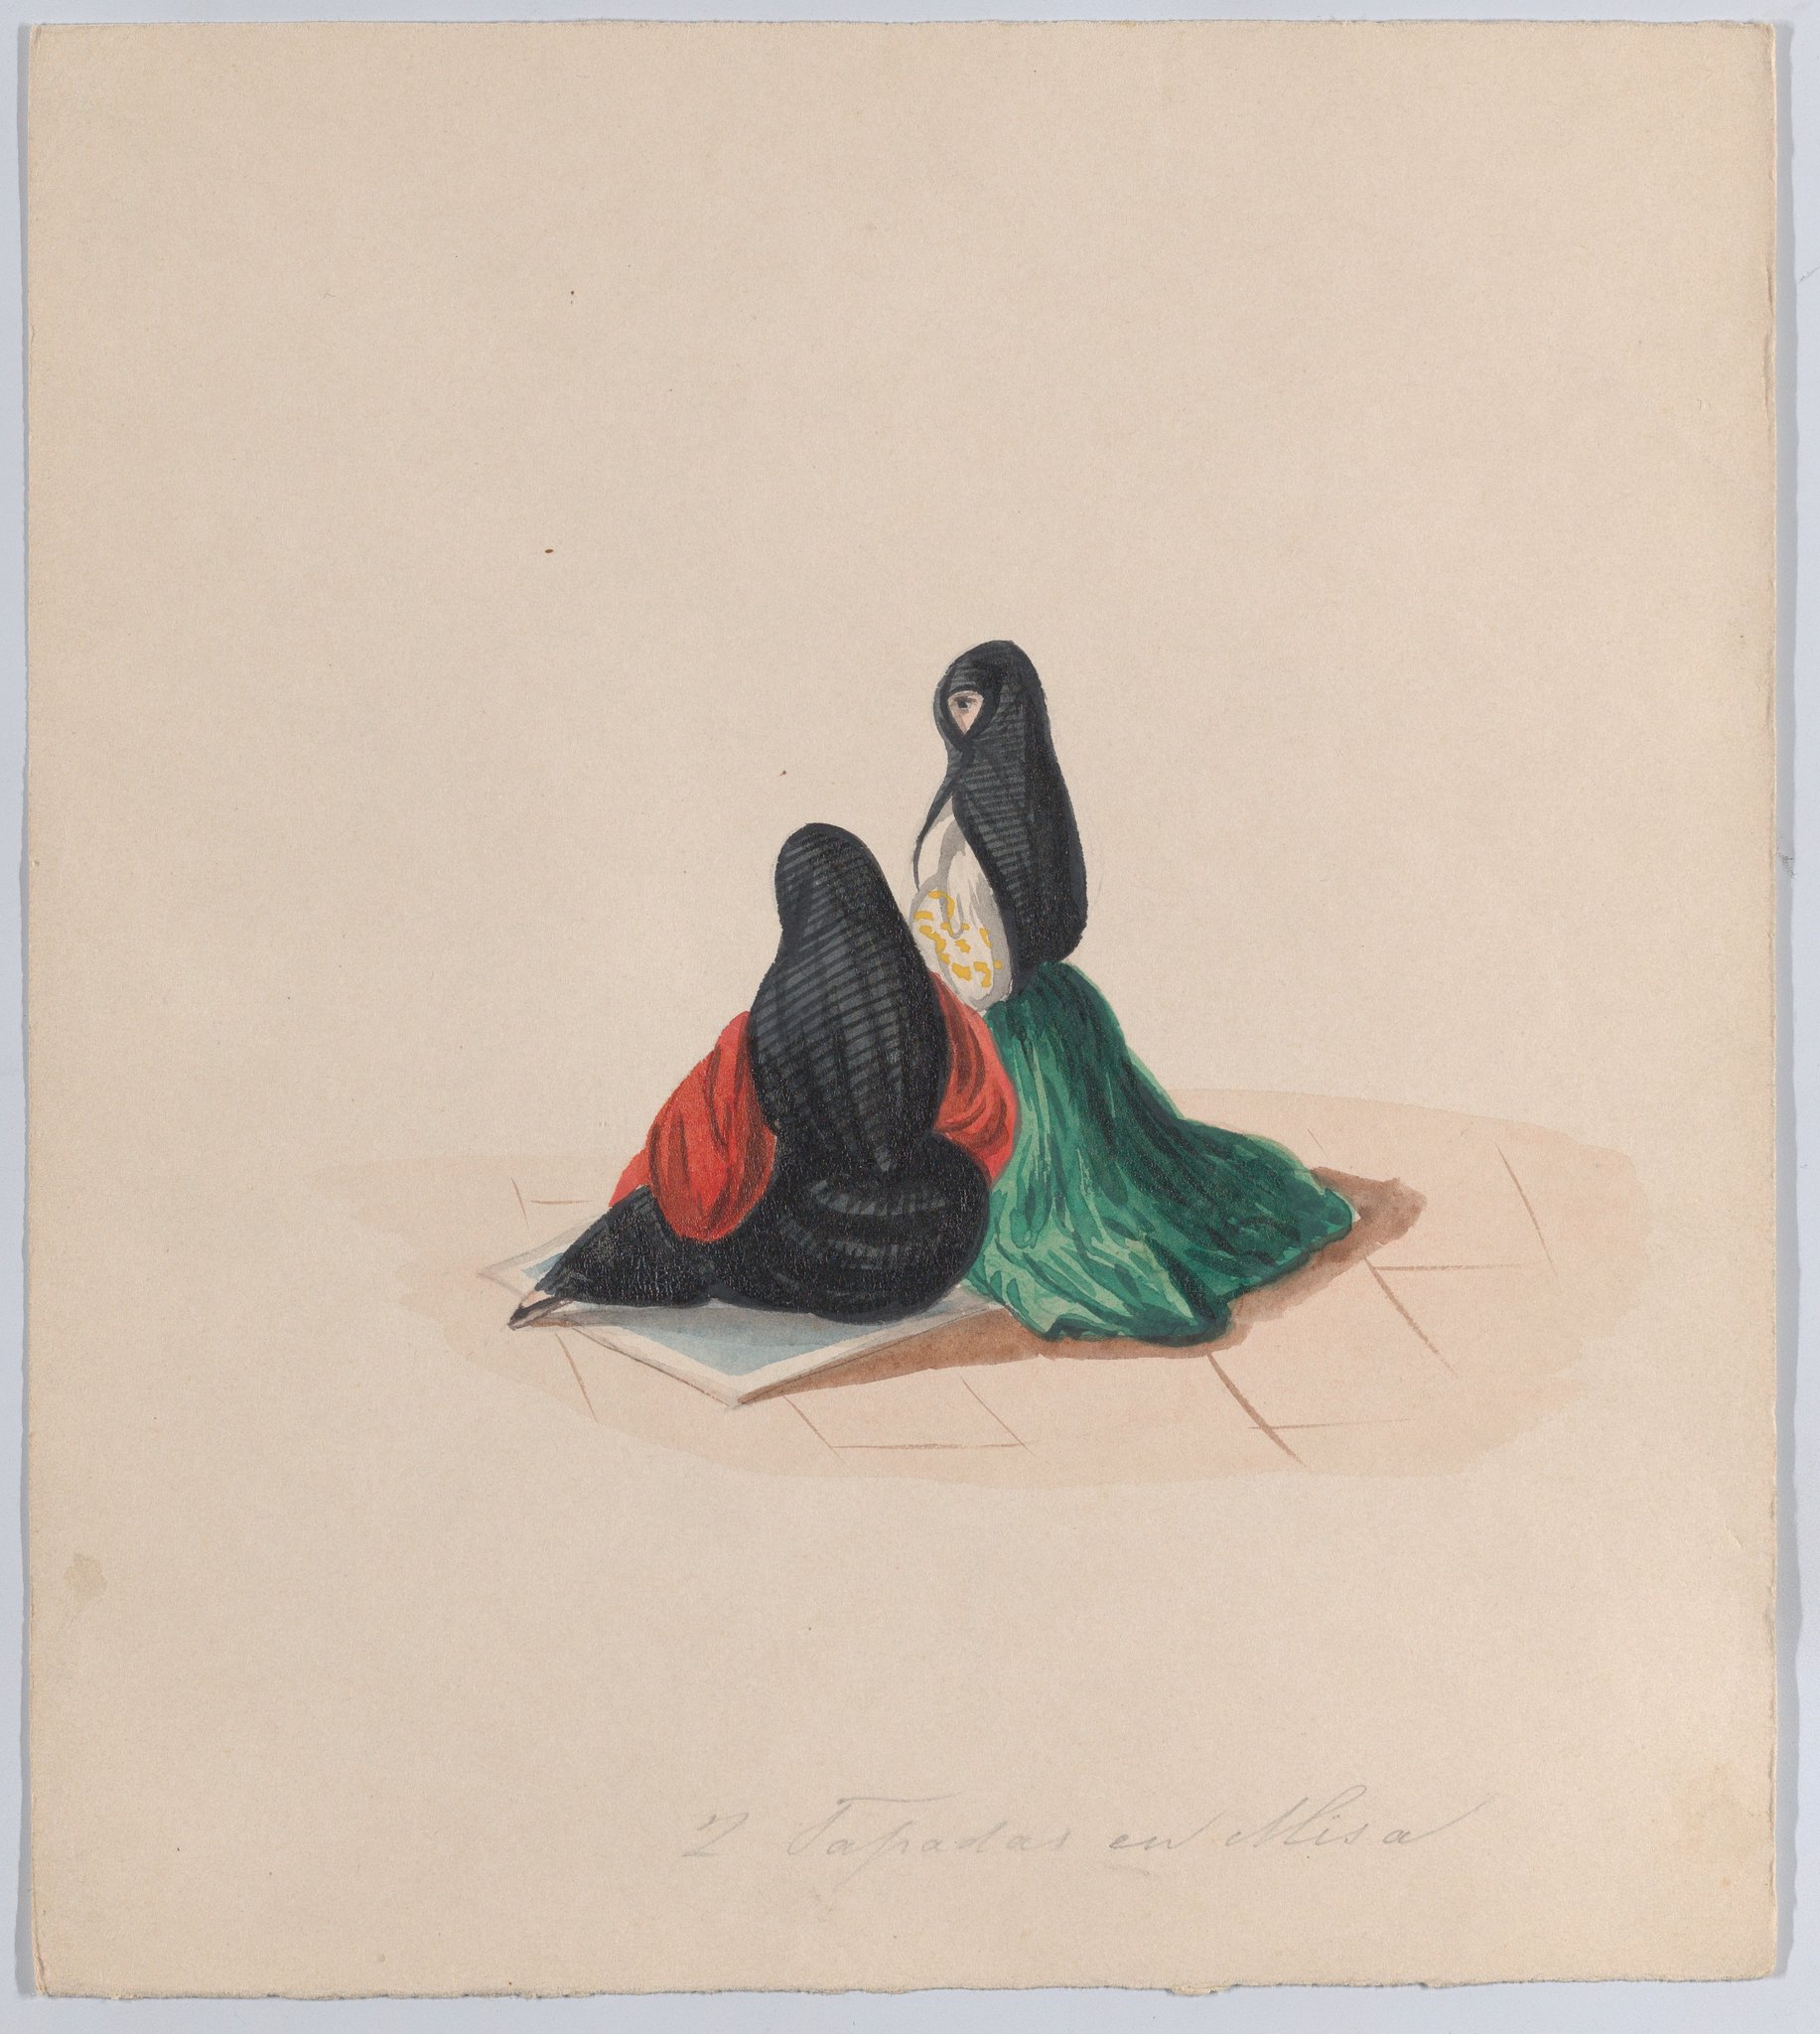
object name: drawing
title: Two woman wearing the saya attending mass, from a group of drawings depicting Peruvian dress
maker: francisco (pancho) fierro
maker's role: artist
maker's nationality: african peruvian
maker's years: 1807-1879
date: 1848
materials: watercolor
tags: women